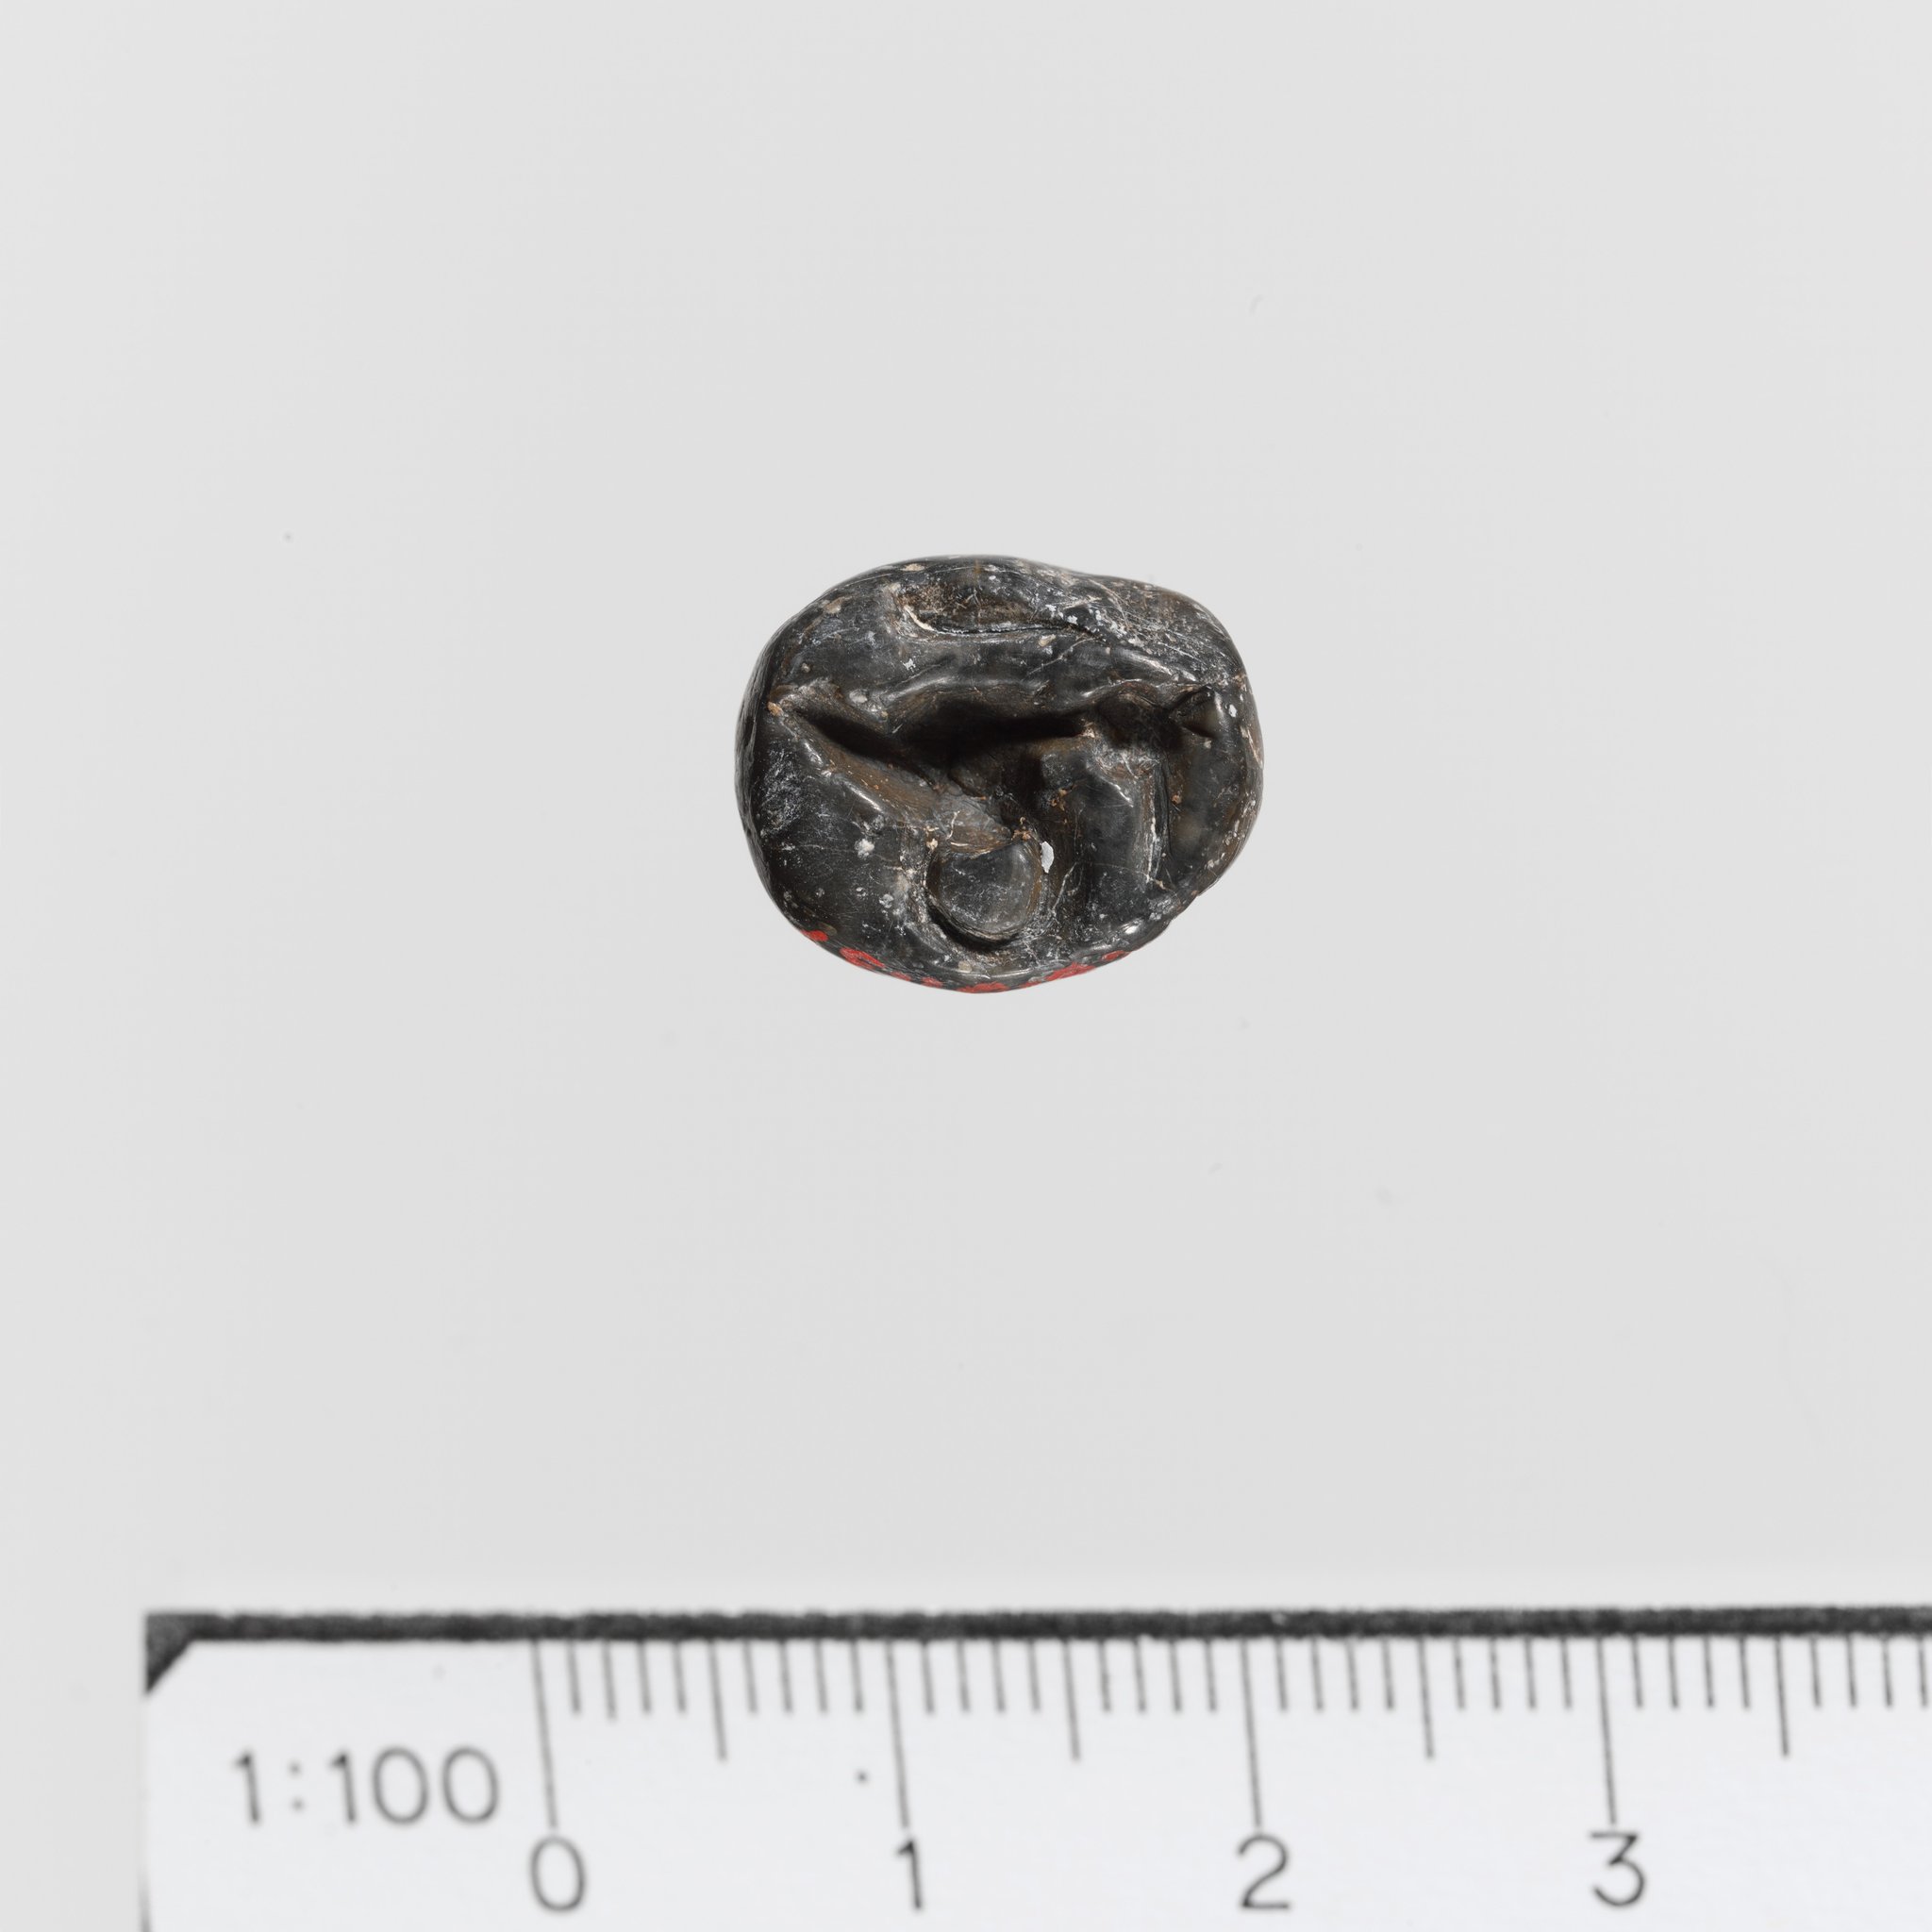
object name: seal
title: Steatite truncated conoid seal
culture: minoan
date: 2400-2200 BCE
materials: stone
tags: birds